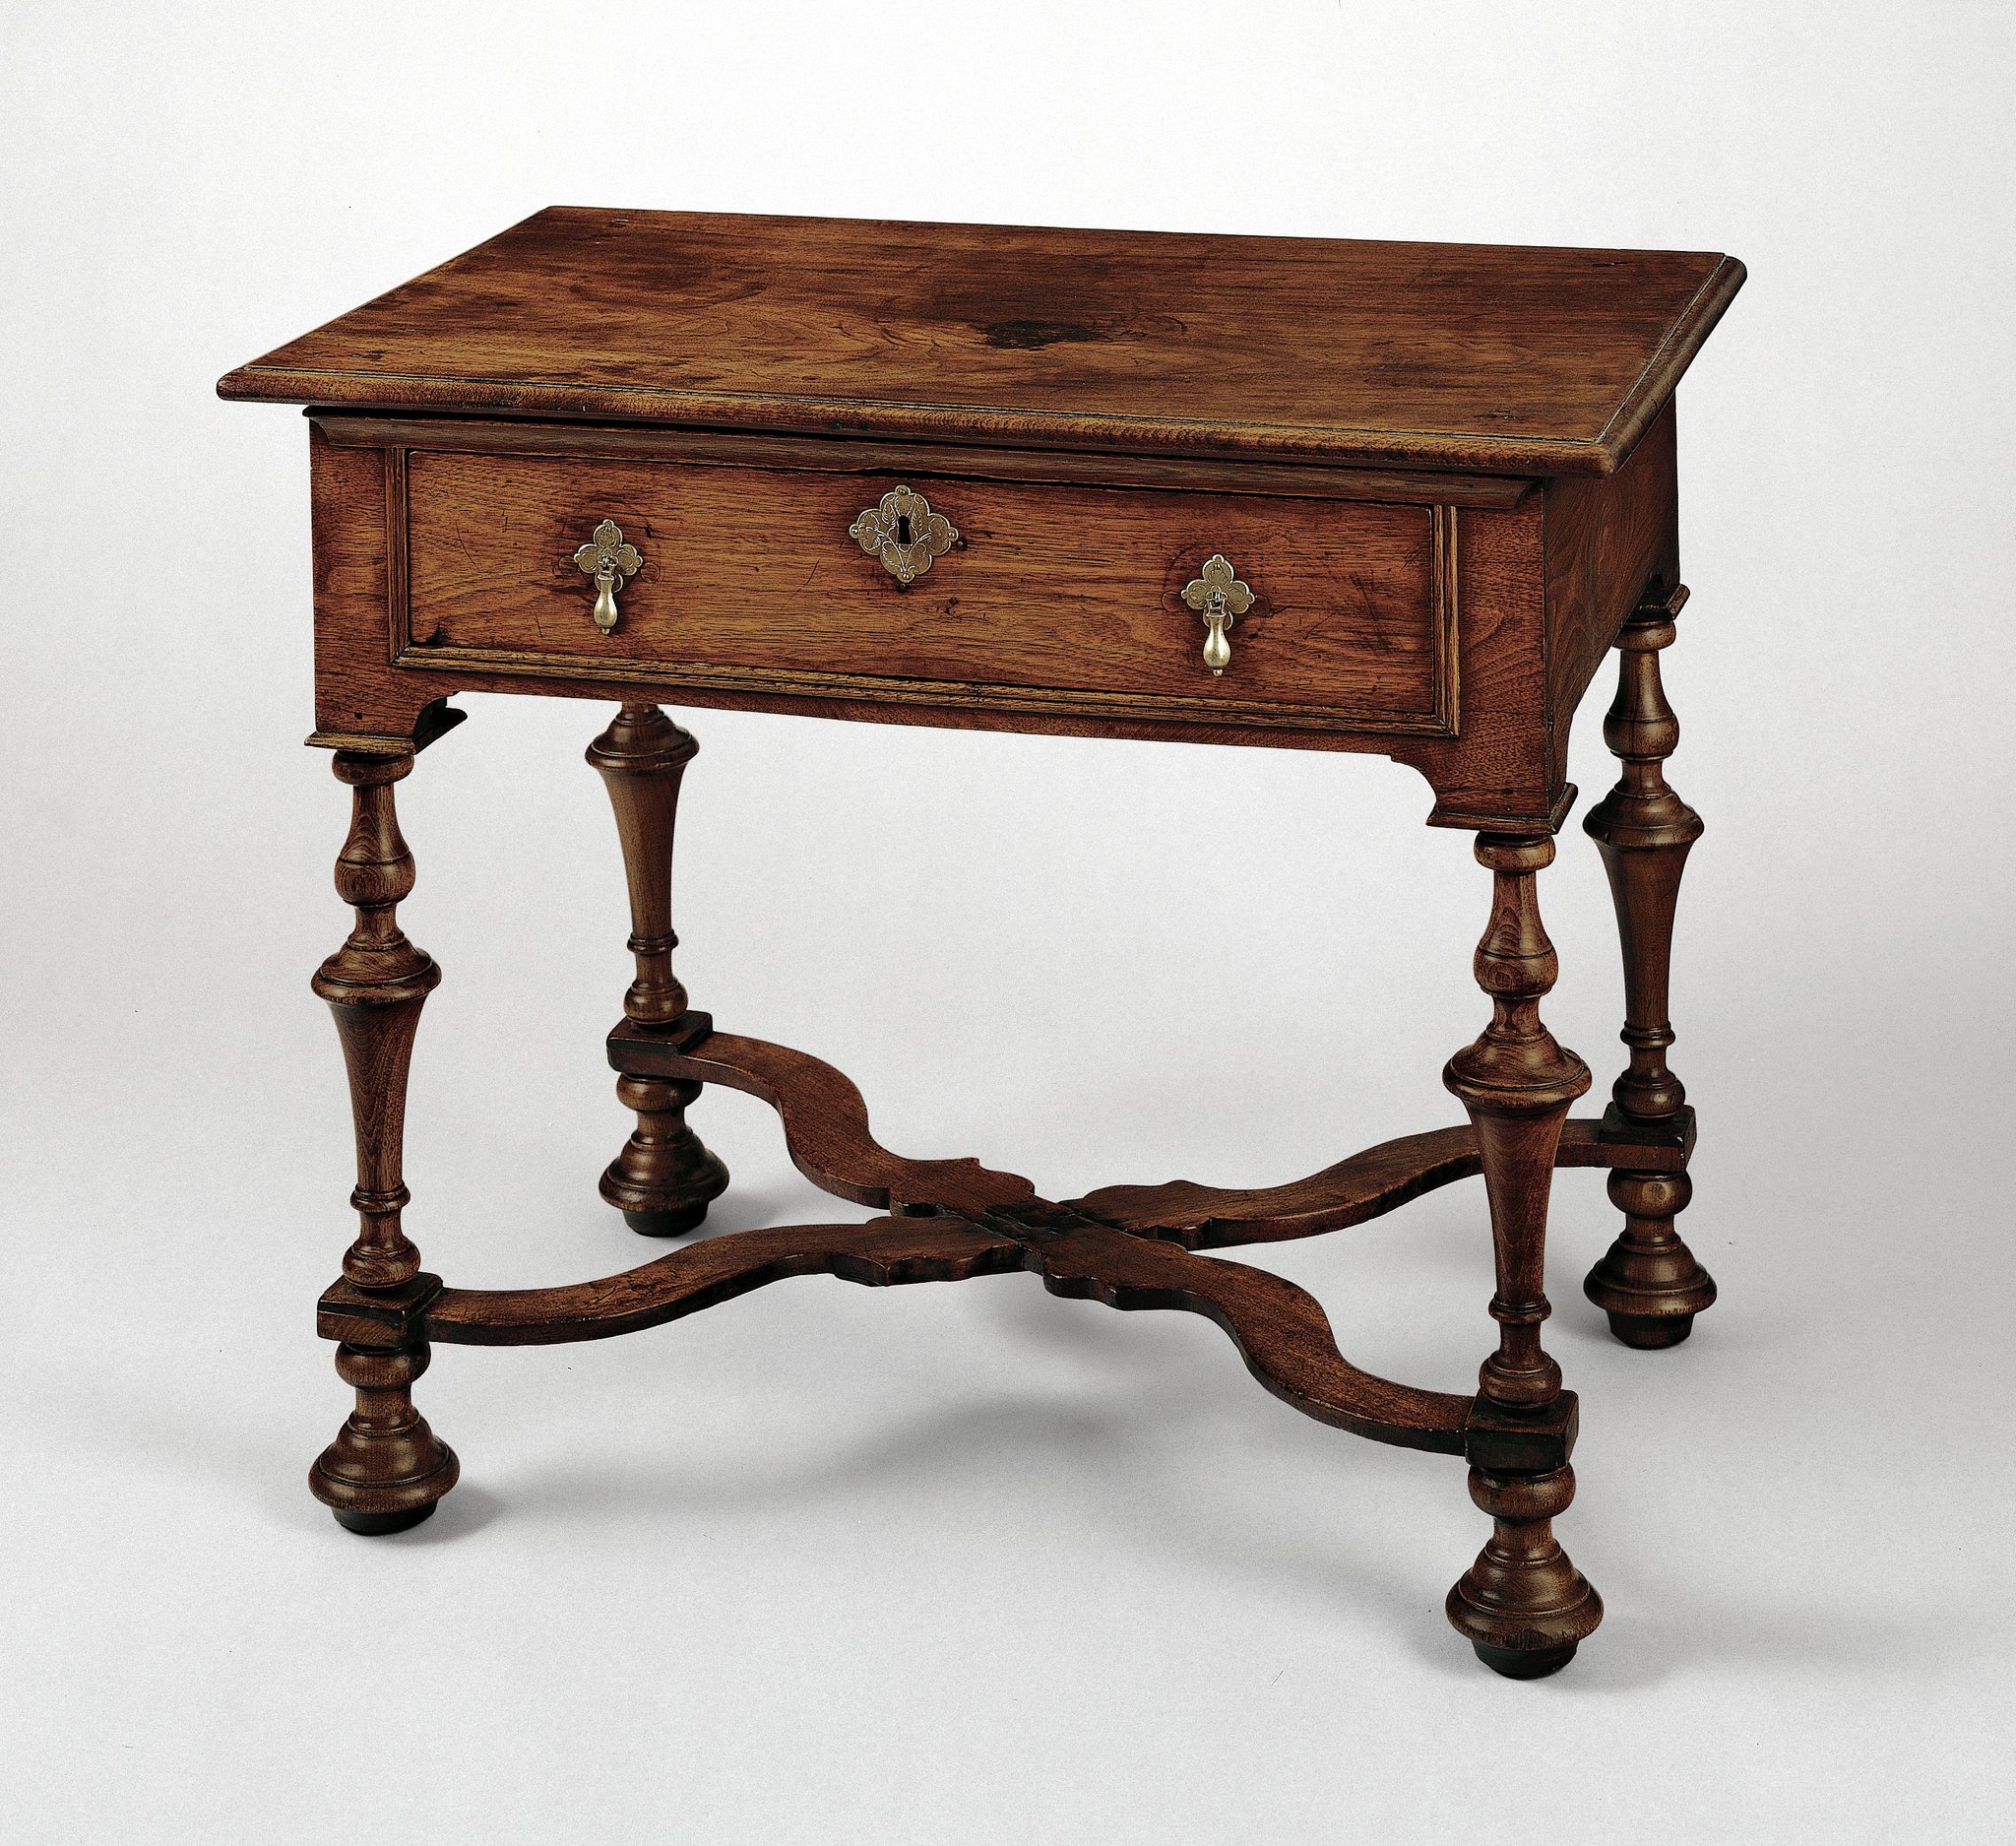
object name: dressing table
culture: american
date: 1710-1730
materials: wood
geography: united states